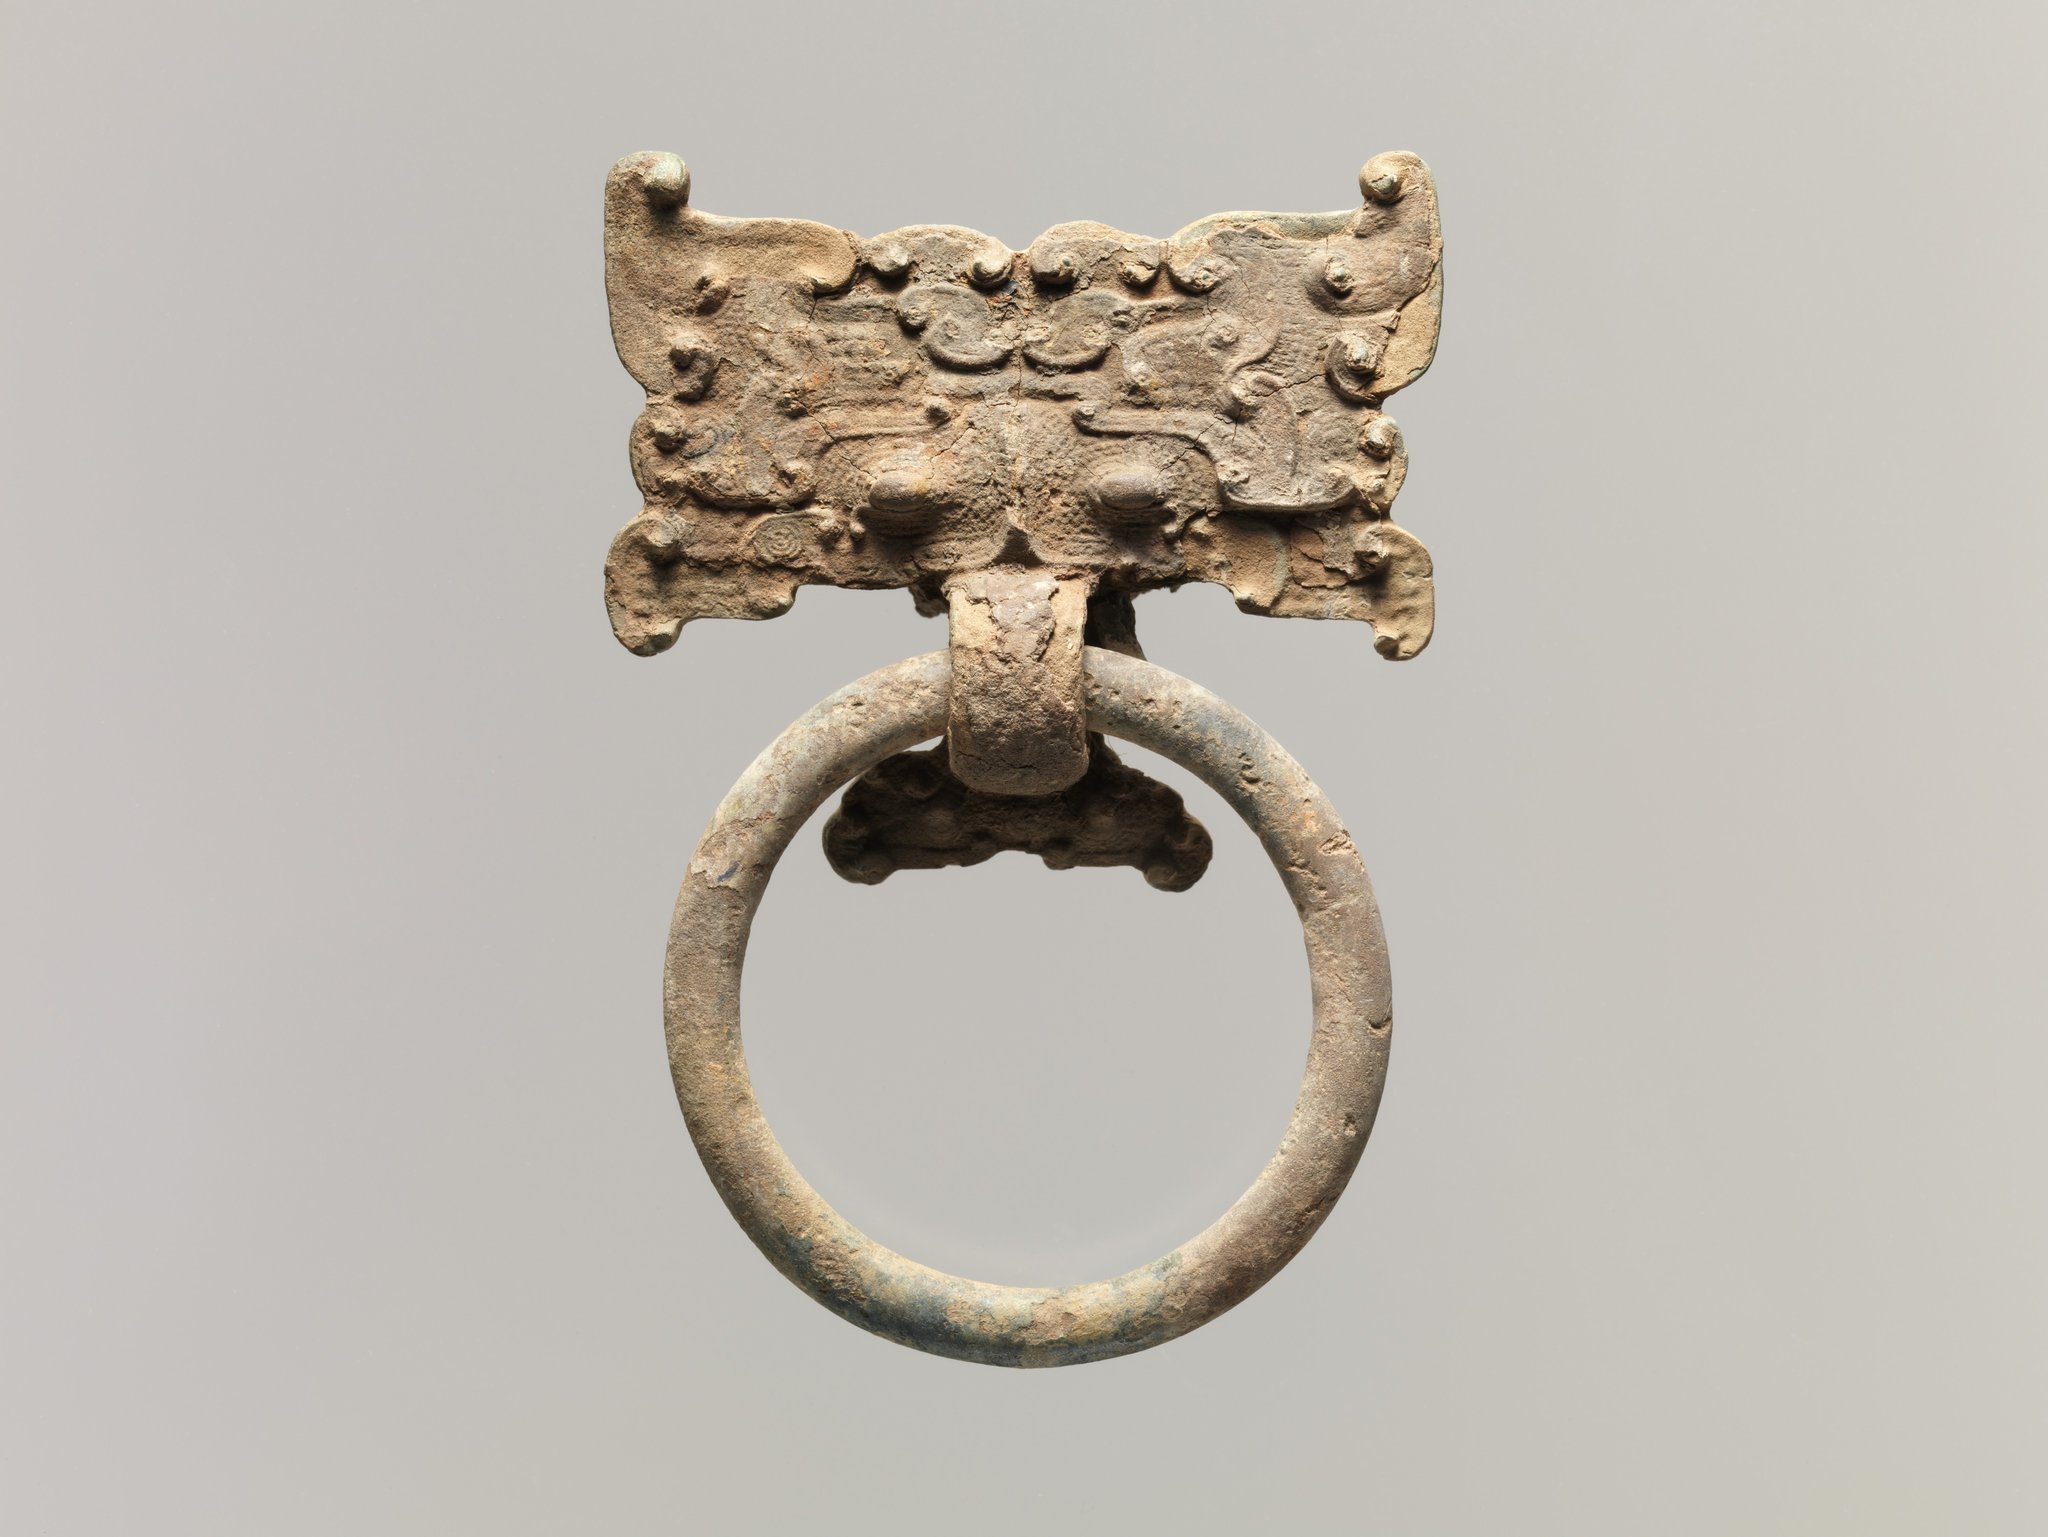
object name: ring handle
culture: chinese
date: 770-256 BCE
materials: bronze